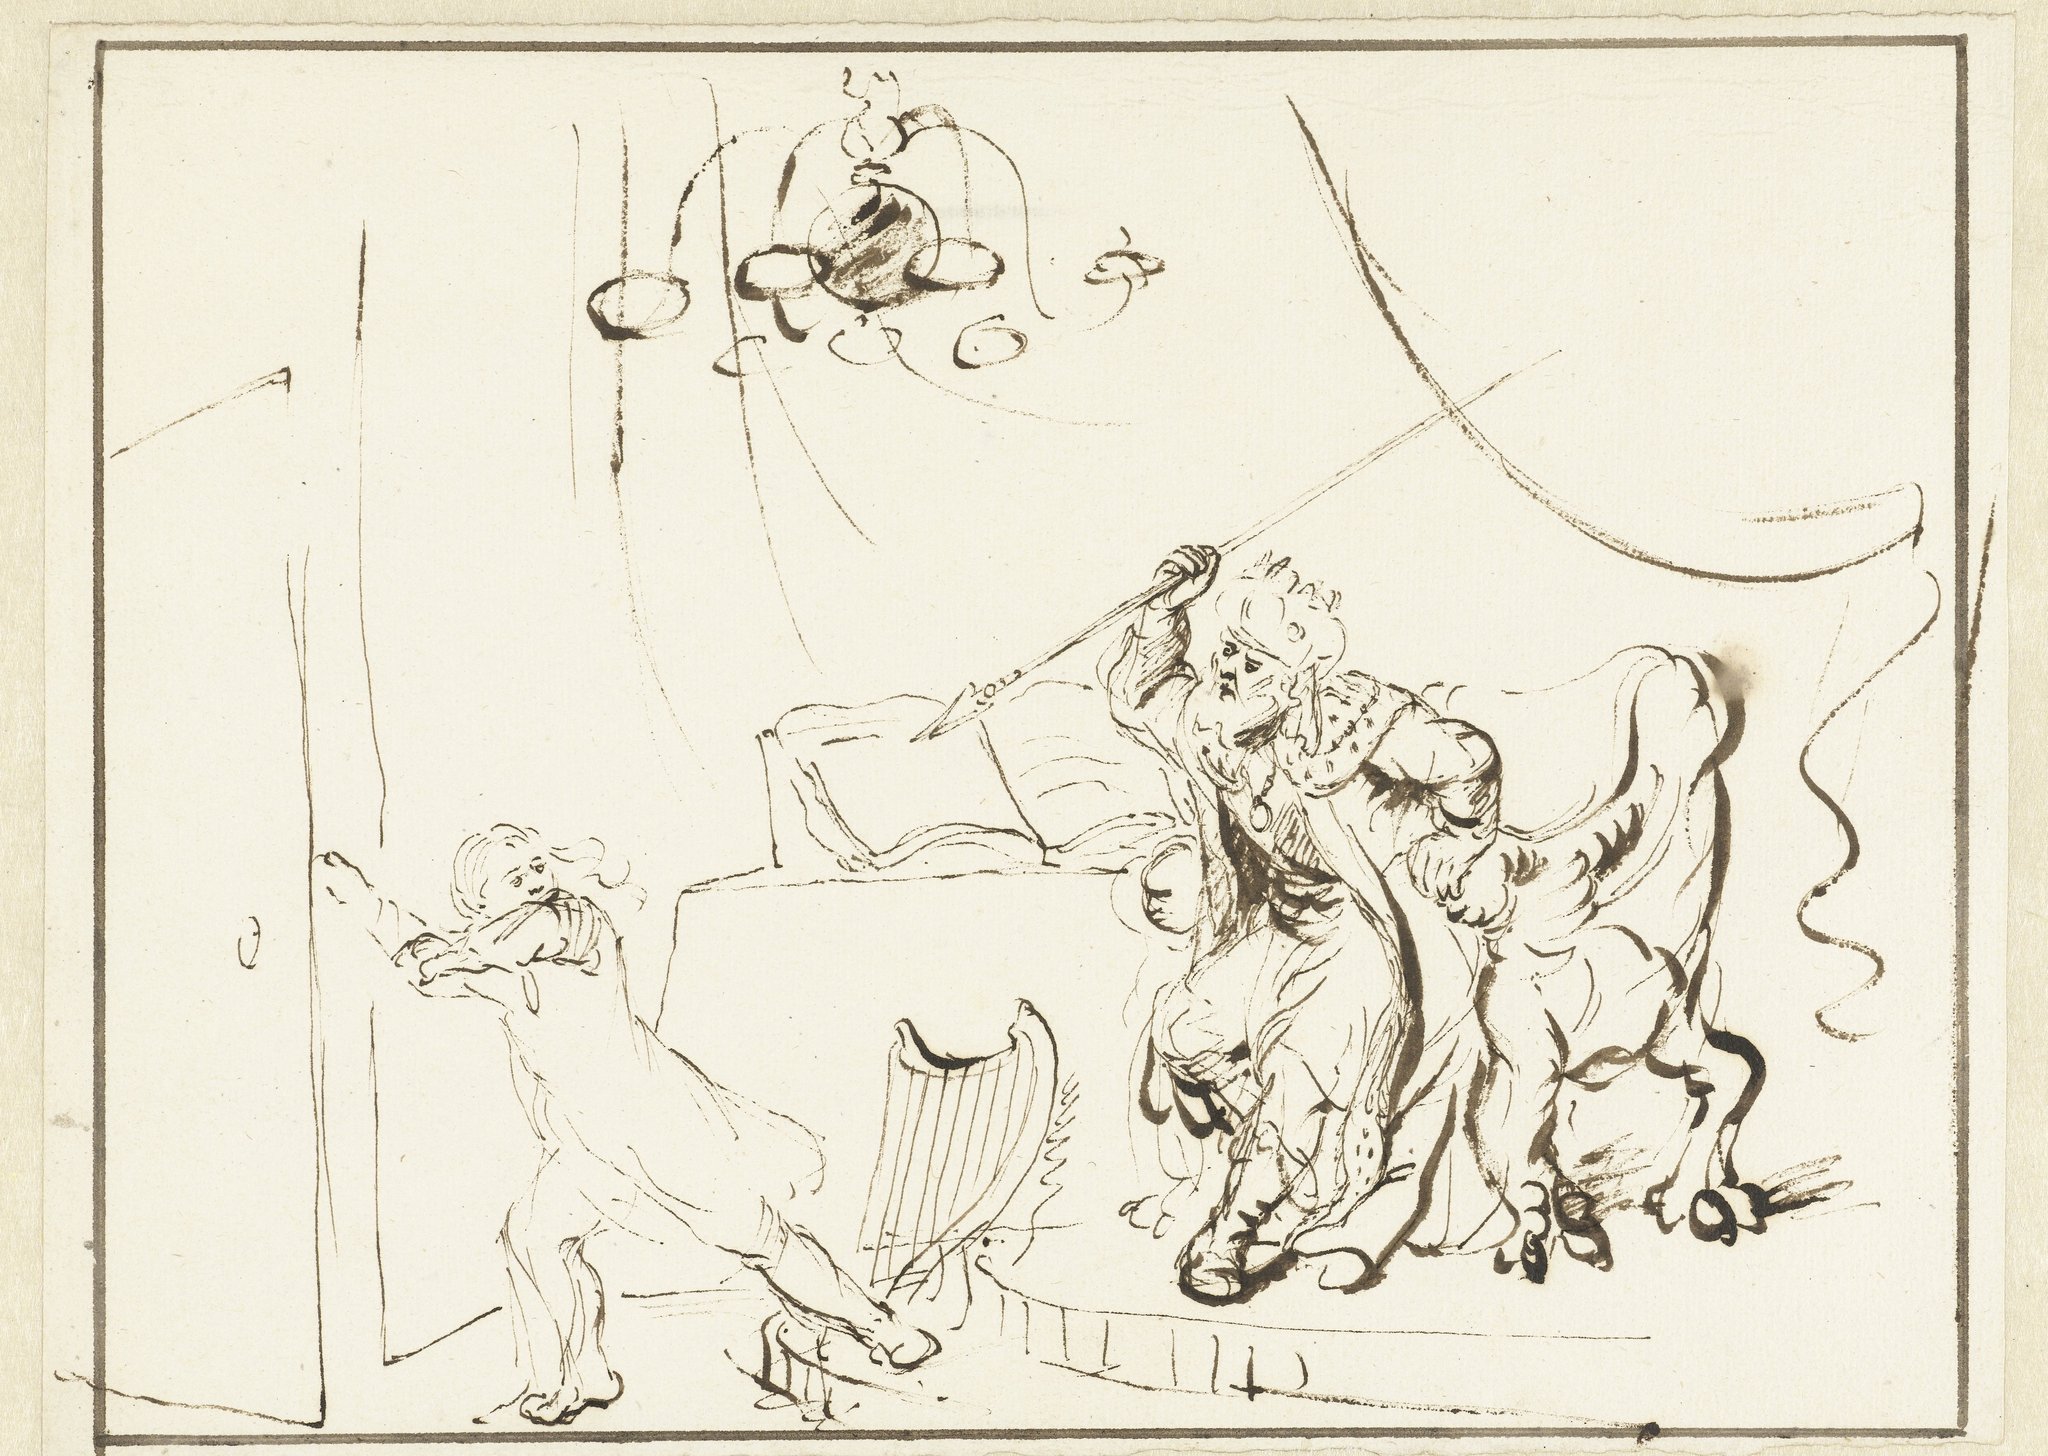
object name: drawing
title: Bijbelse voorstellingen voor album van Matthijs Balen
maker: nicolaes maes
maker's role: draughtsman, painter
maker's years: 1634-1693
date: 1650-1660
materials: ink, paper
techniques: pen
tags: saul casts his spear at david for the second time (1 samuel 19:10)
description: Afkomstig uit een album met losliggende tekeningen van met name Matthijs Balen.